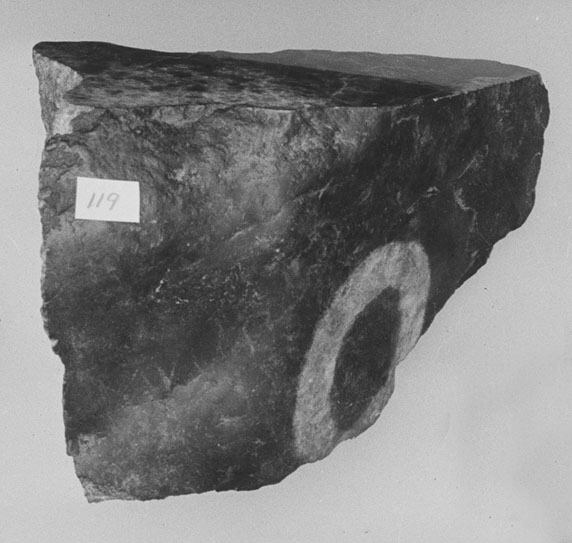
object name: fragment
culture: russian, siberia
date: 1902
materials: jade